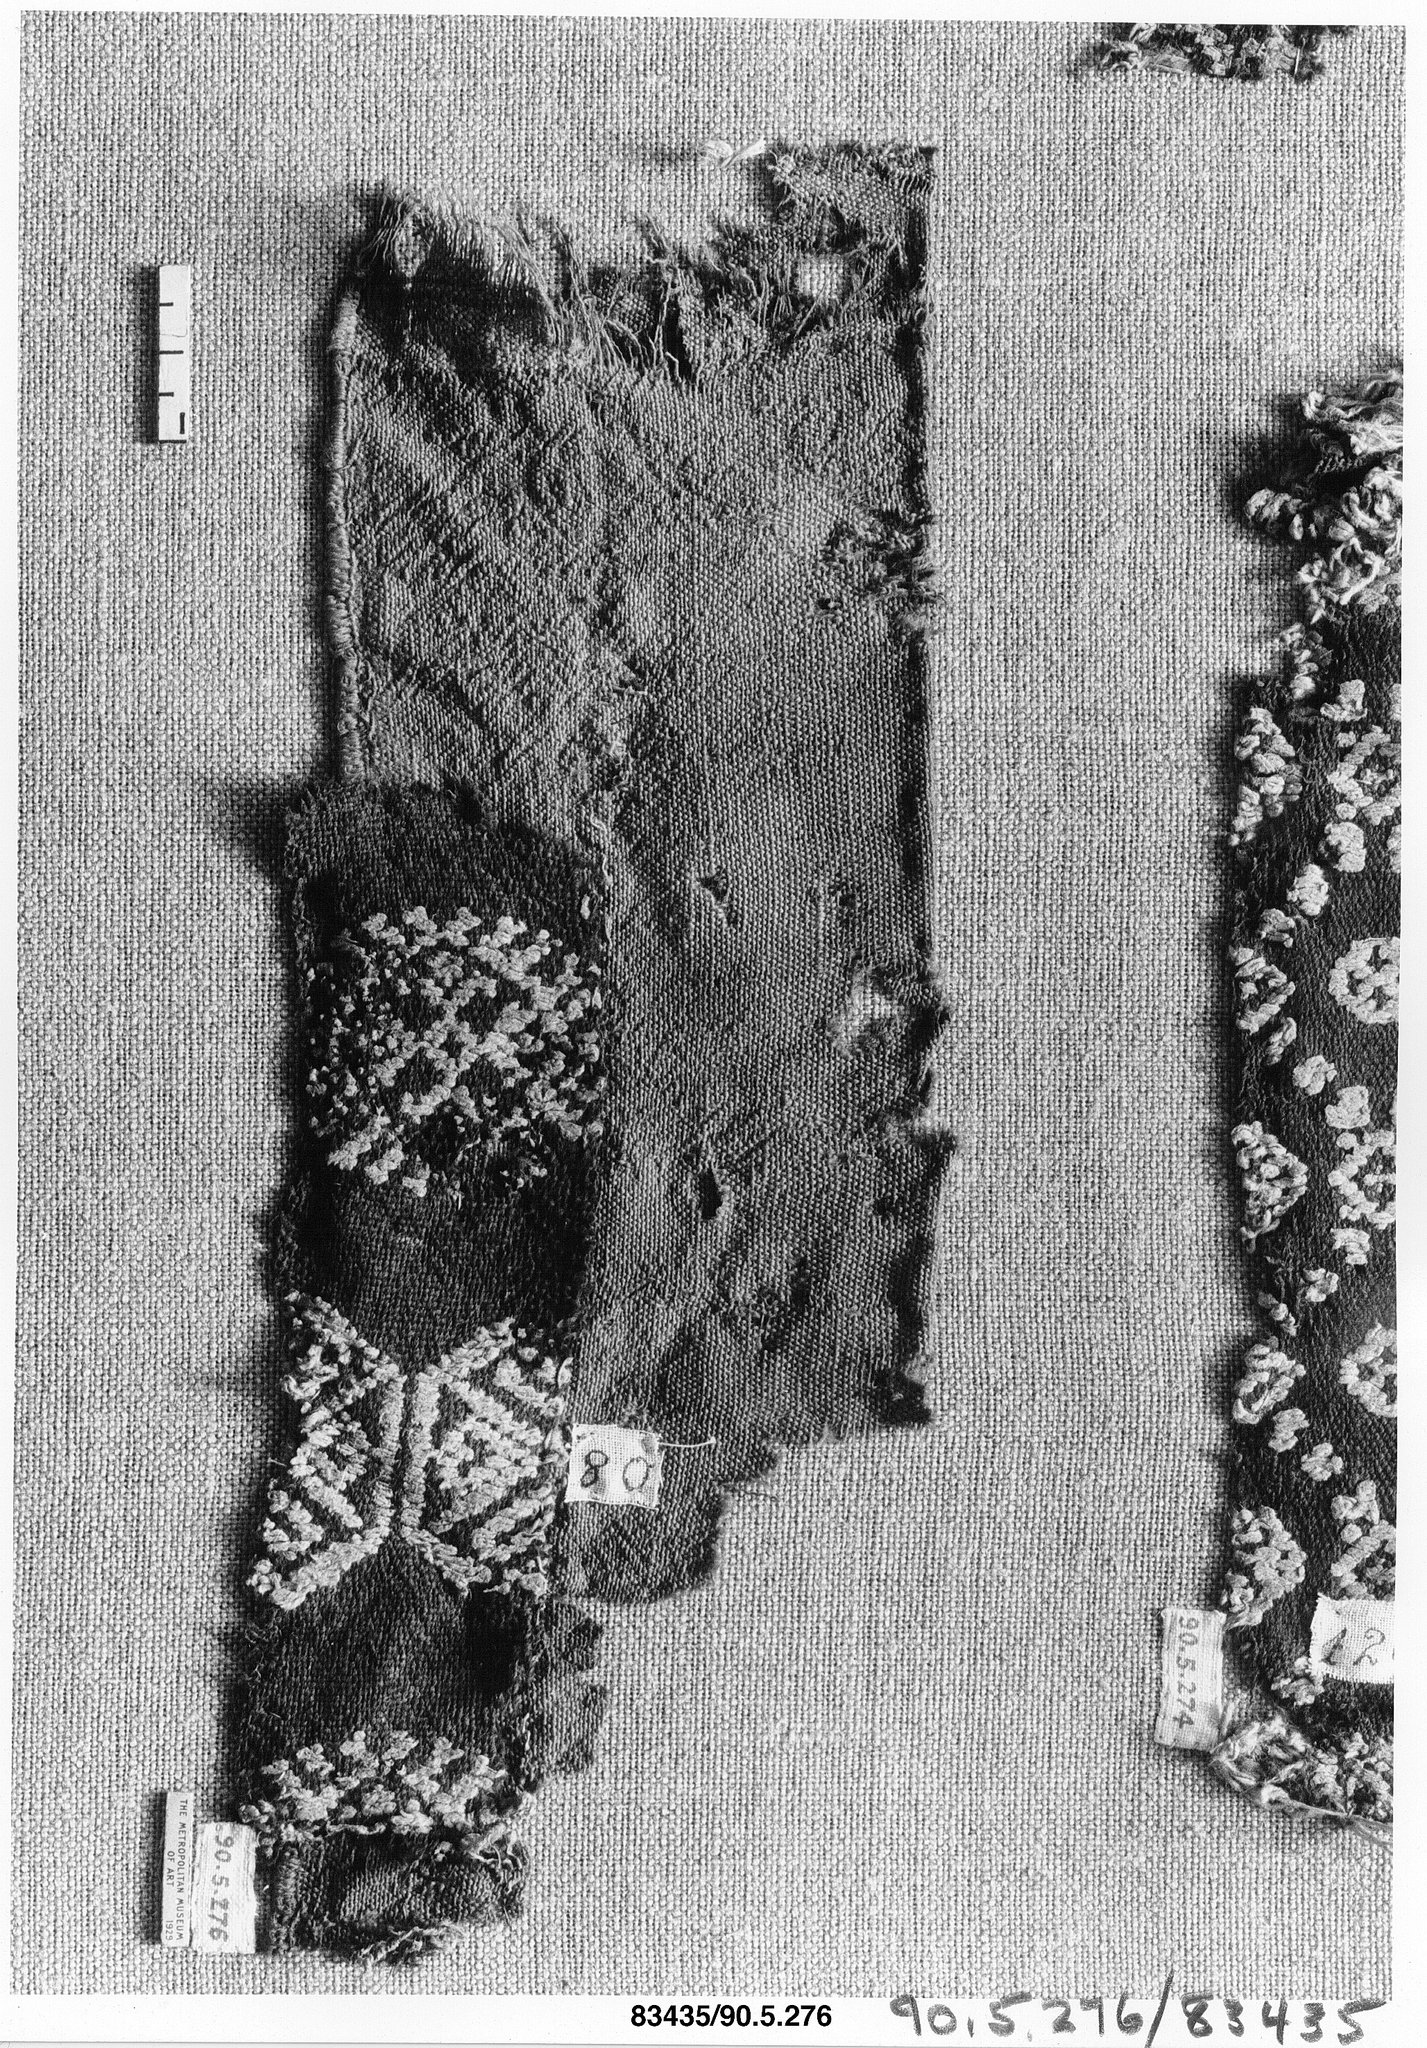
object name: textile fragment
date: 401-600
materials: linen, wool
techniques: weave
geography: egypt